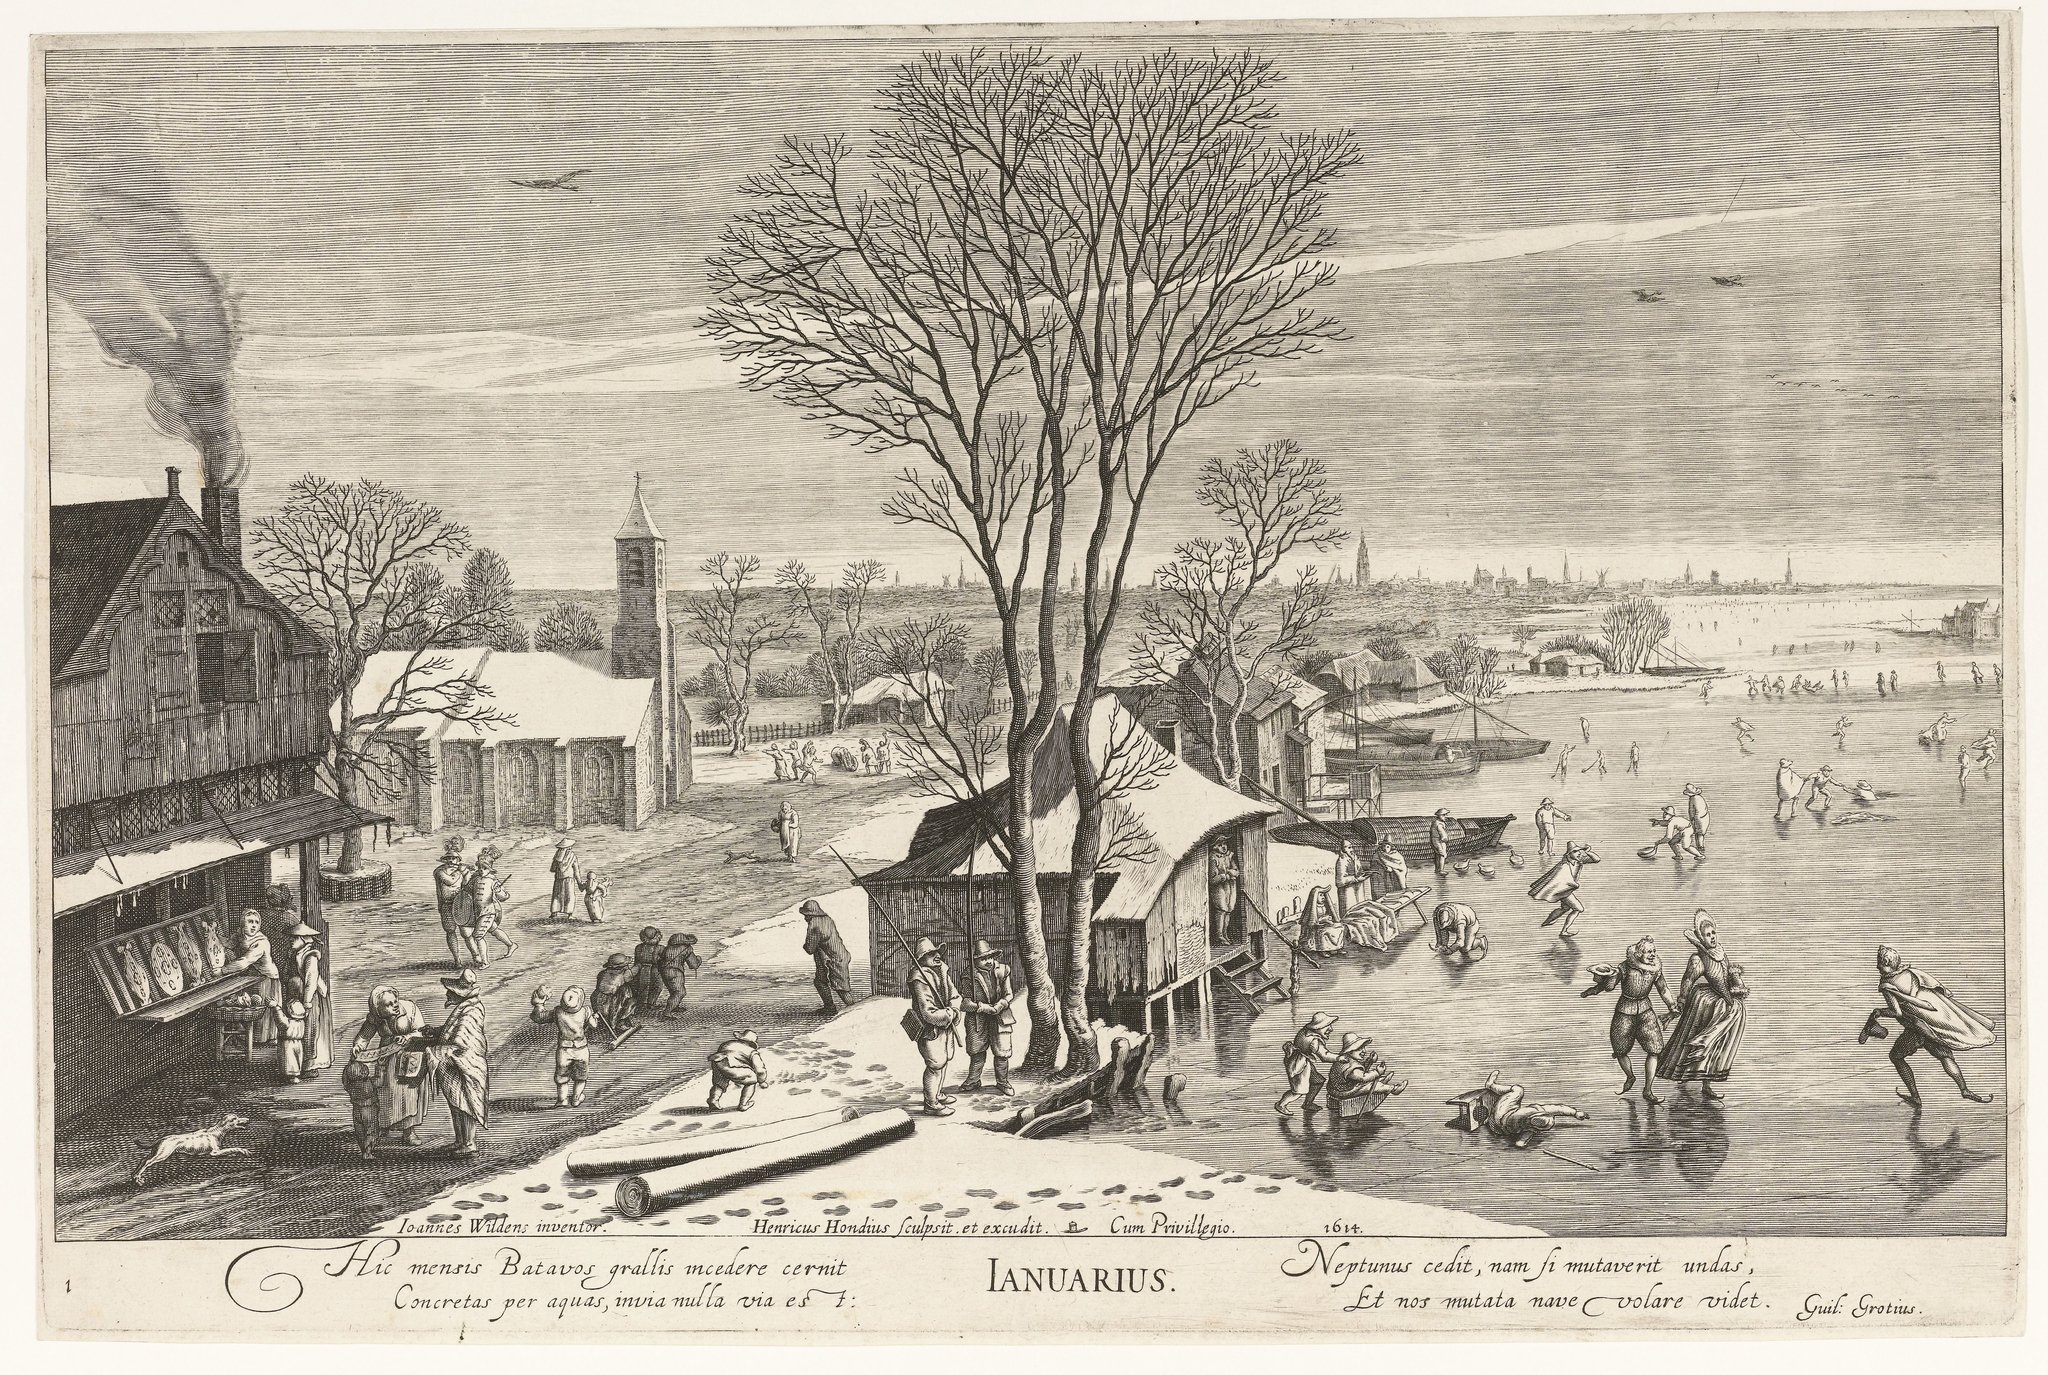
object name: print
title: Januarius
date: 1614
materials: paper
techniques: engraving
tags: january and its 'labours', skates (winter sports), landscape symbolizing january (+ with scenes showing human occupations ~ seasons and months)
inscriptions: signature and address: ‘Henricus Hondius sculpsit. et excudit.’, collector's mark: Lugt 240, signature:, privilege: ‘Cum Privillegio.’, number: ‘1’, date: ‘1614’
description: Winterlandschap met ijsgezicht en enkele boerenhuizen. Op het ijs, rechts, wordt geschaatst. Links op de voorgrond een winkel waar koek (?) wordt verkocht. Linksachter een kerk. Onderaan (tussen excudit en Cum) de boraxbus als Hondius persoonlijke signatuur. Onder de voorstelling een tekst in het Latijn. Prent uit een serie van de twaalf maanden.